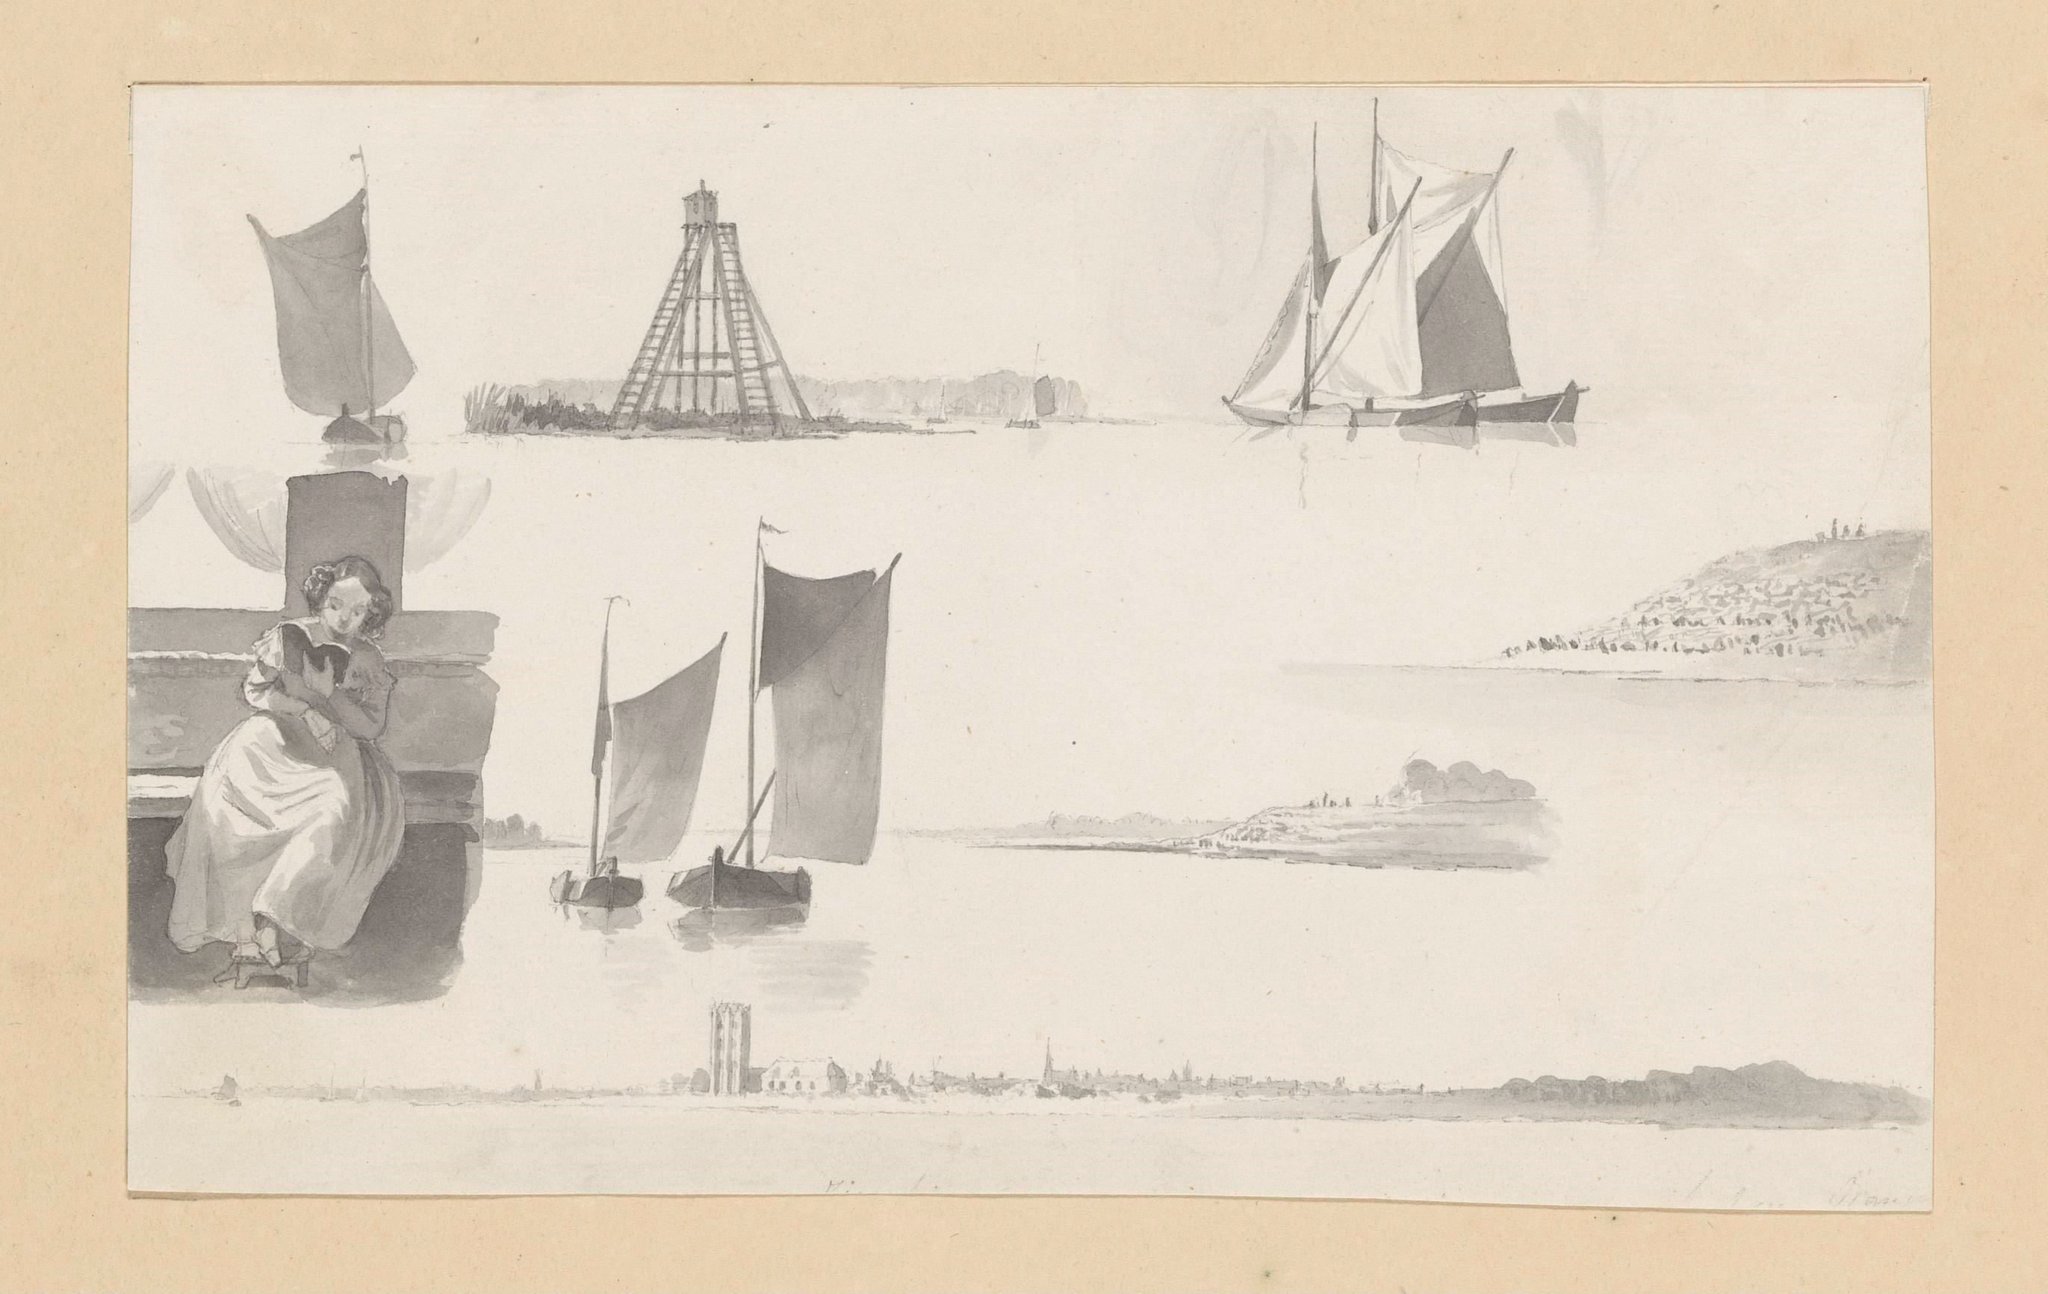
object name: drawing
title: Schetsblad met lezende vrouw, zeilschepen, vuurtoren en gezichten van de wal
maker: hendrik abraham klinkhamer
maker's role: draughtsman, painter, print maker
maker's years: 1810-1872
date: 1851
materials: paper, pencil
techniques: brush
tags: lighthouse, lightship, sailing-ship, sailing-boat, reading